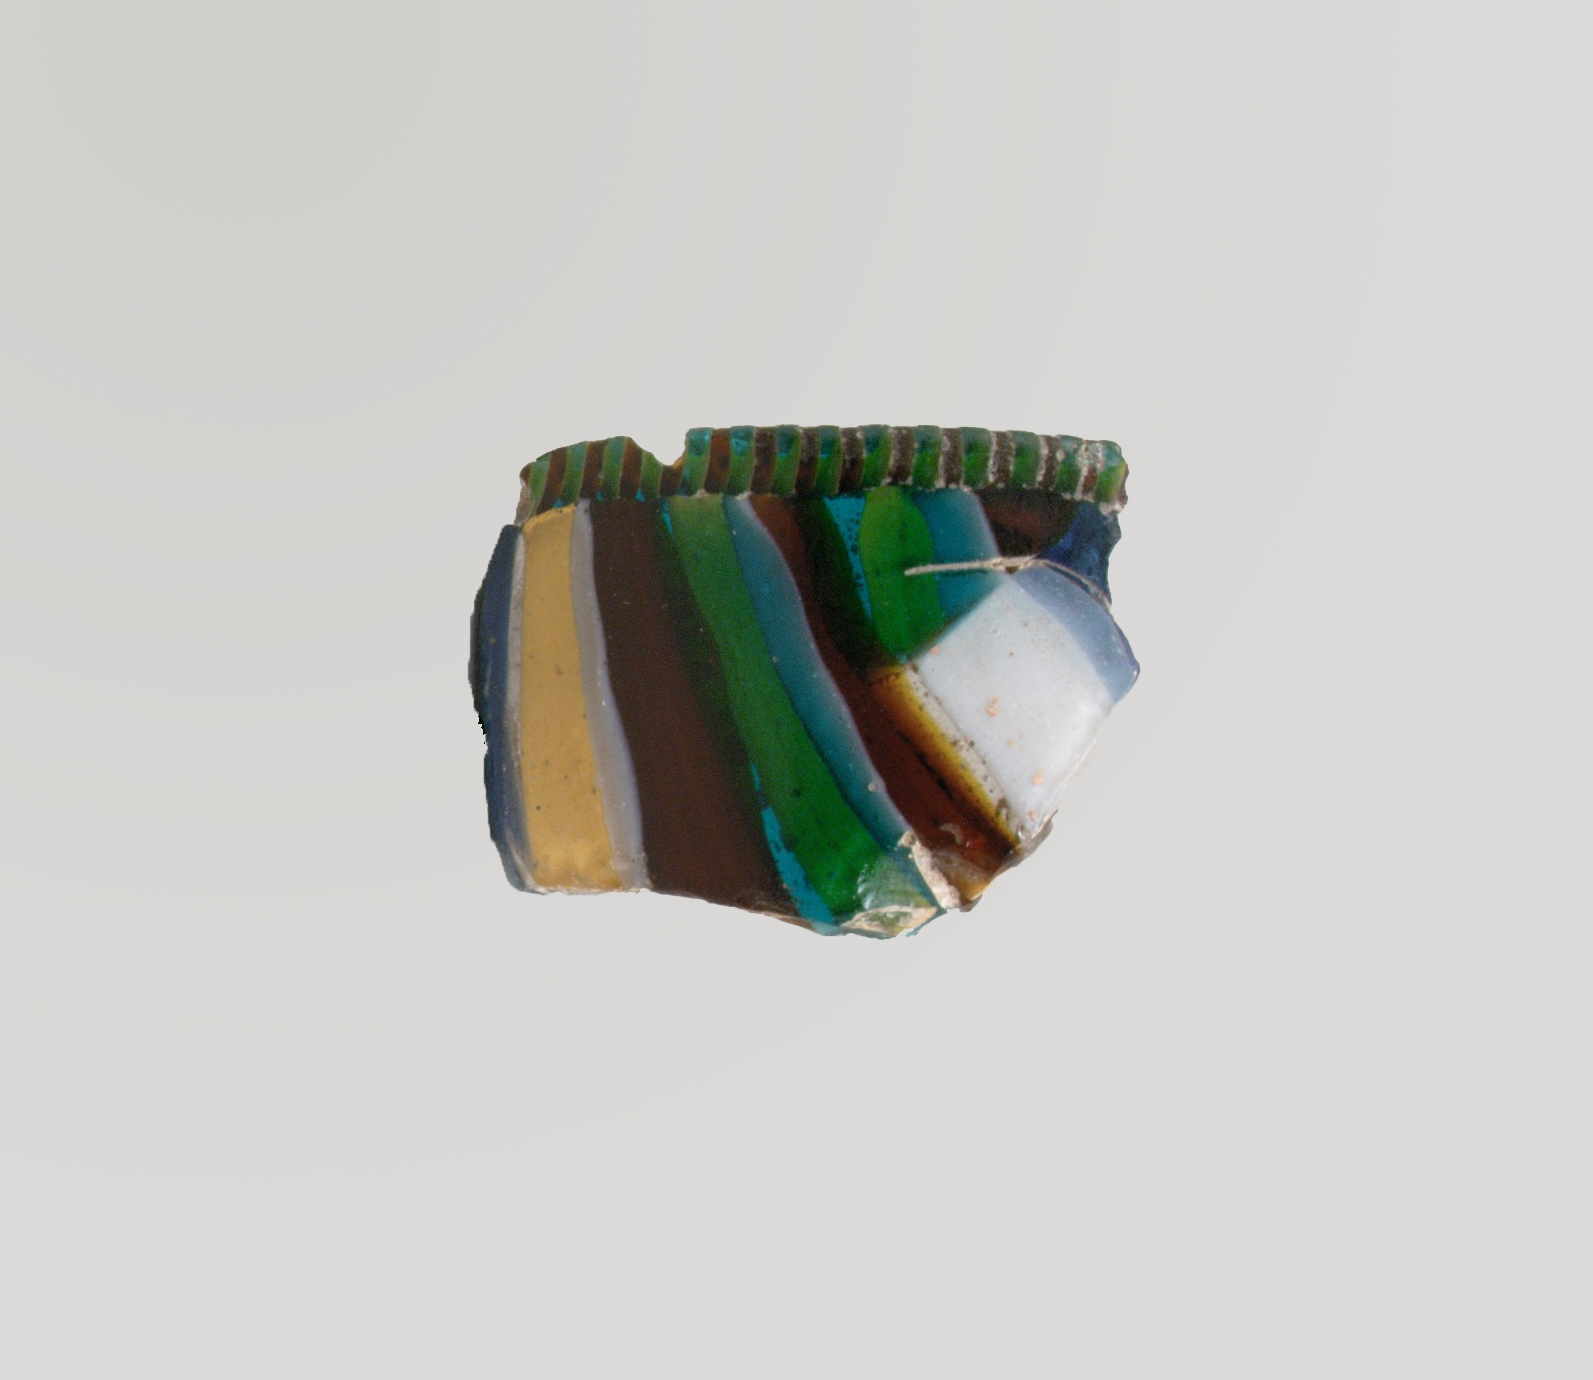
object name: fragment, striped mosaic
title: Glass striped mosaic bowl fragment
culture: roman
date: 34 BCE-33 CE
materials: glass